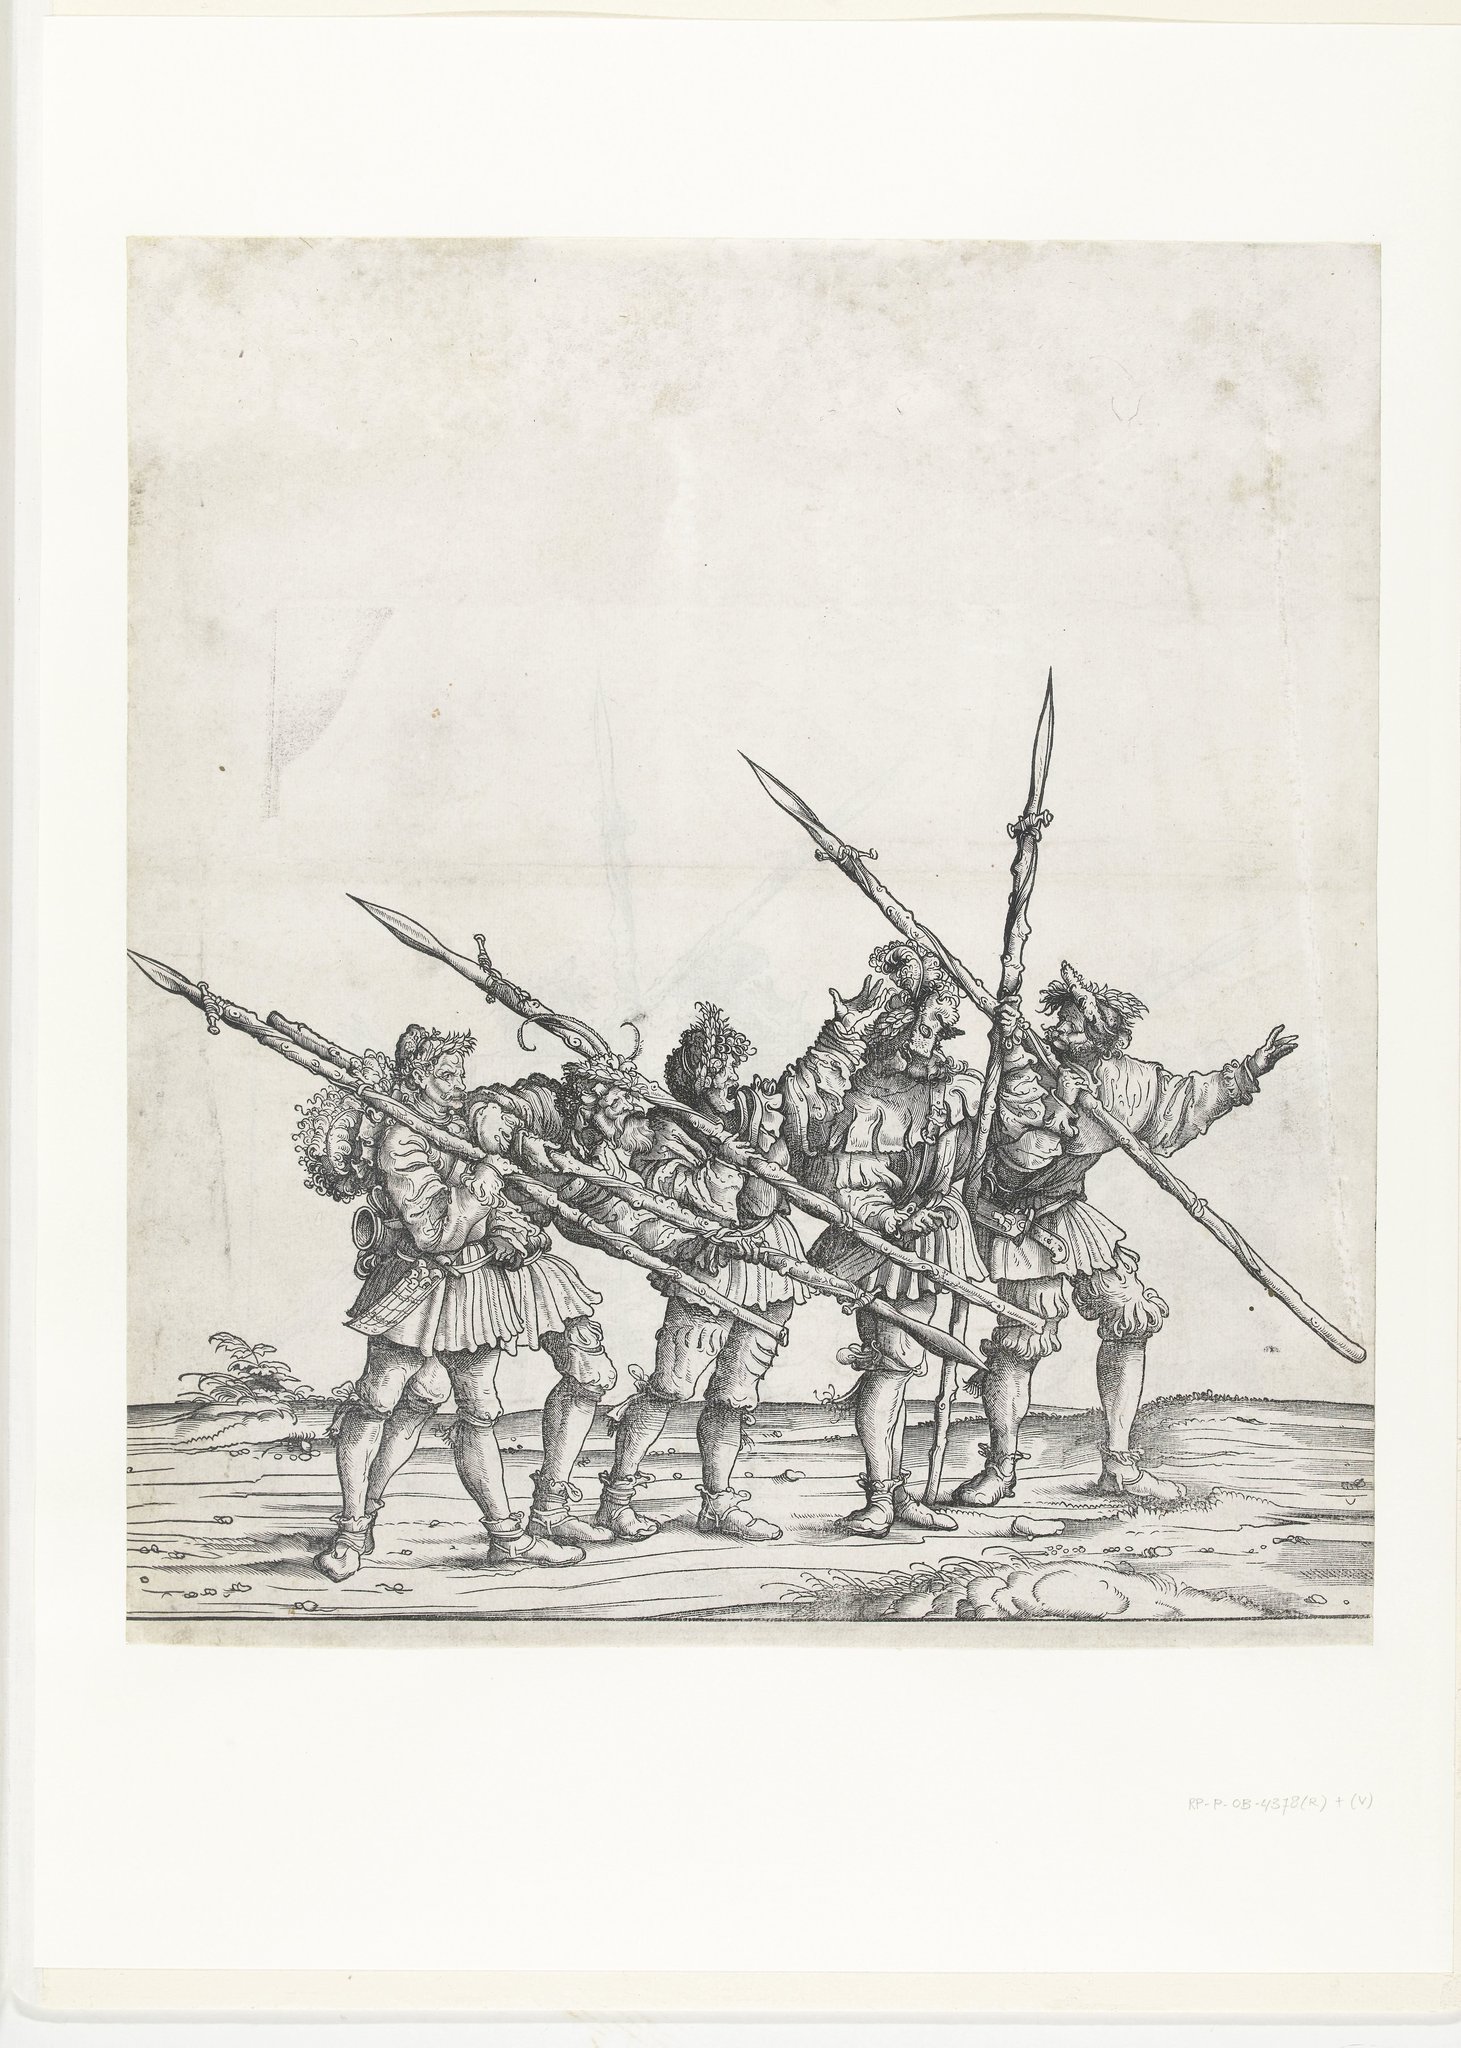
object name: print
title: Triomfen van Keizer Maximiliaan I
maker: hans burgkmair (i)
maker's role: draughtsman, print maker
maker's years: 1473-1531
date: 1483-1526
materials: paper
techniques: woodcut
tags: symbolic triumphs of individual persons, hunters resting during the hunt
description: Houtblok gebruikt voor: Marx Treitzsaurwein, Triomf van Keizer Maximiliaan I, 1526. Volgens Biedermann zijn de prenten uit de triomf in de collectie van het RMA proefdrukken (Biedermann 1973, niet gepagineerd). Op dit blad is hetzelfde houtblok op zowel recto als verso gedrukt.